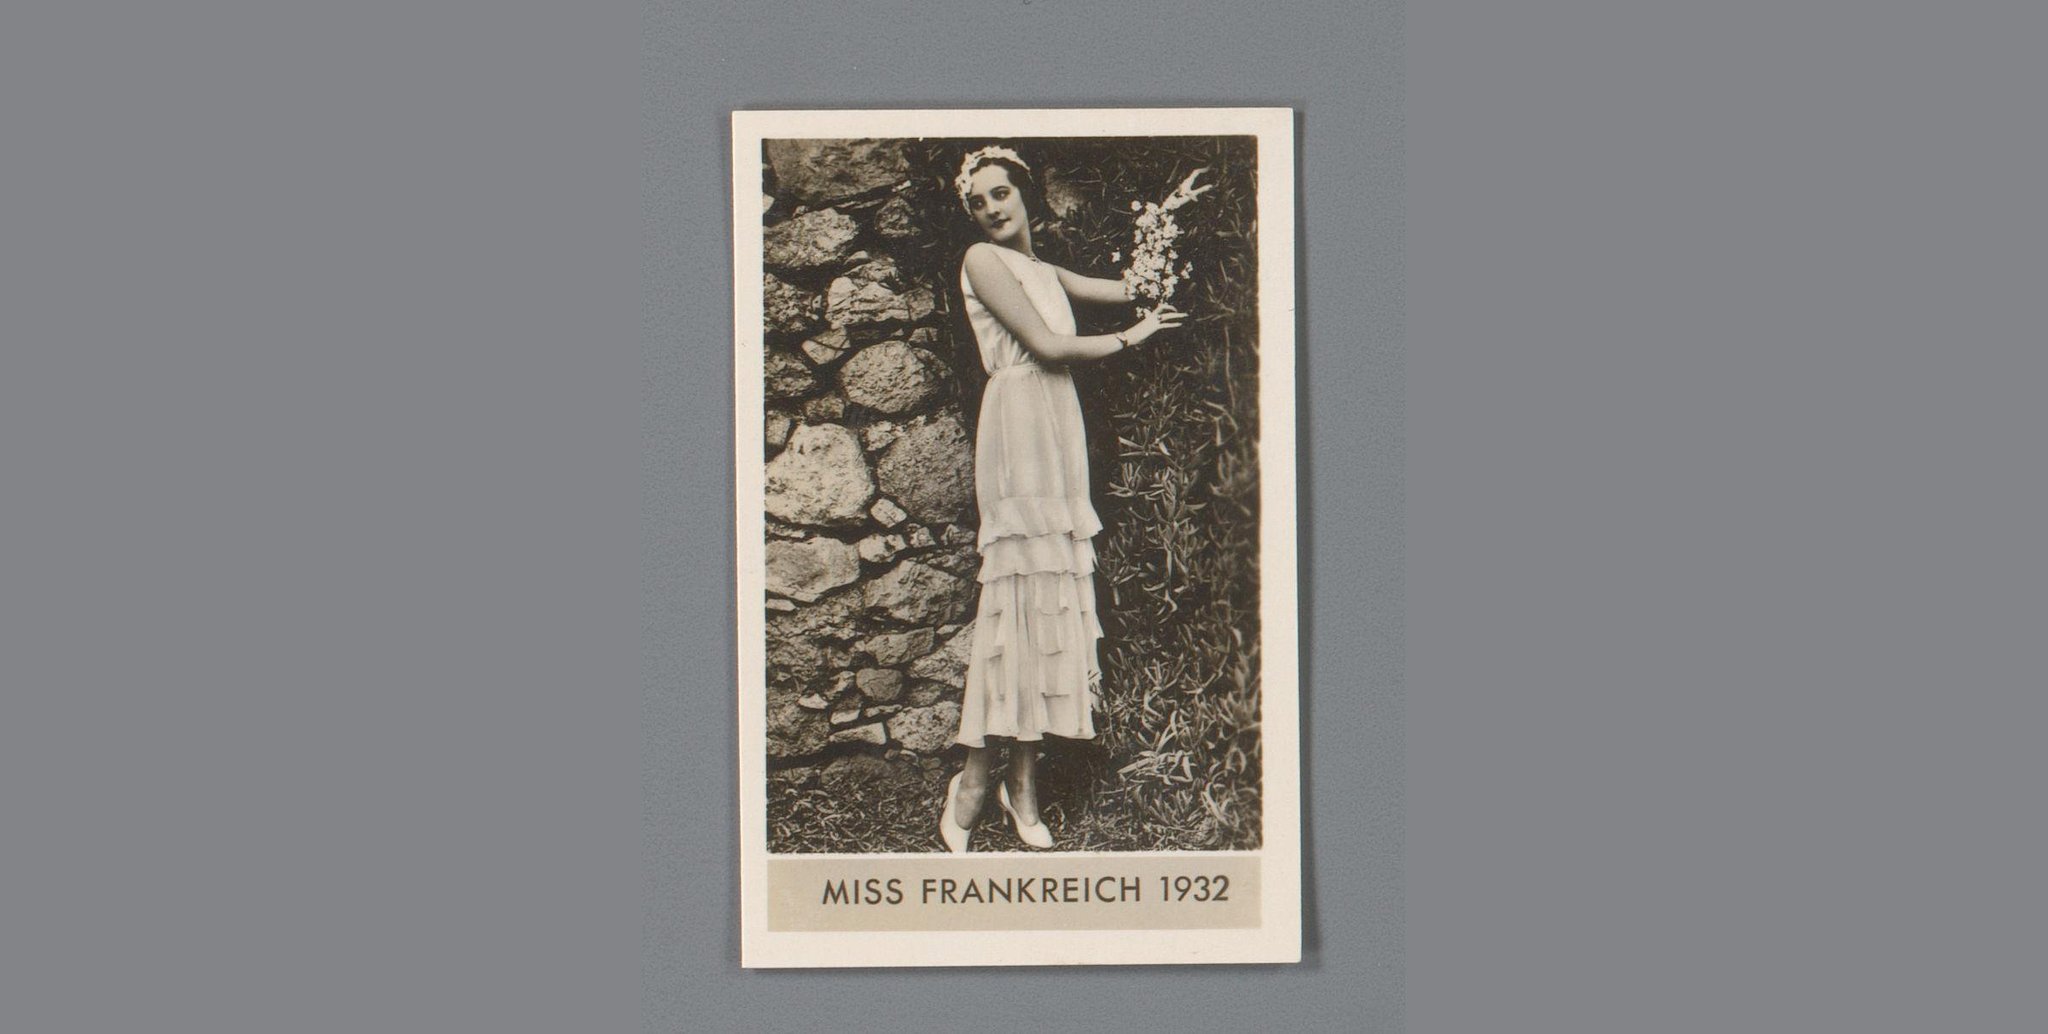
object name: photograph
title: Miss Frankreich 1932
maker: Anonymous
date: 1932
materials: paper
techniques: gelatin silver print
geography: dresden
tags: historical persons - bb - woman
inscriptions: inscription: ‘Die schönsten/ Frauen der Welt/ dargestellt durch die Schön-/ heitsköniginnen aller Länder,/ finden Sie in 190 echten/ Bromsilber-Fotos, die nur den/ CLUB-und-LIGA-Packun-/ gen beiliegen. Eind prächtiges/ Sammel-Album erhalten Sie/ für 75 Pfennig vom Händler/ oder bei Einsendung von/ 75 Pfennig in Briefmarken/ von der Bilderstelle Lohse,/ Dresden A24, Nossener Str. 1./ Ges. gesch. Nachdruck verboten!’